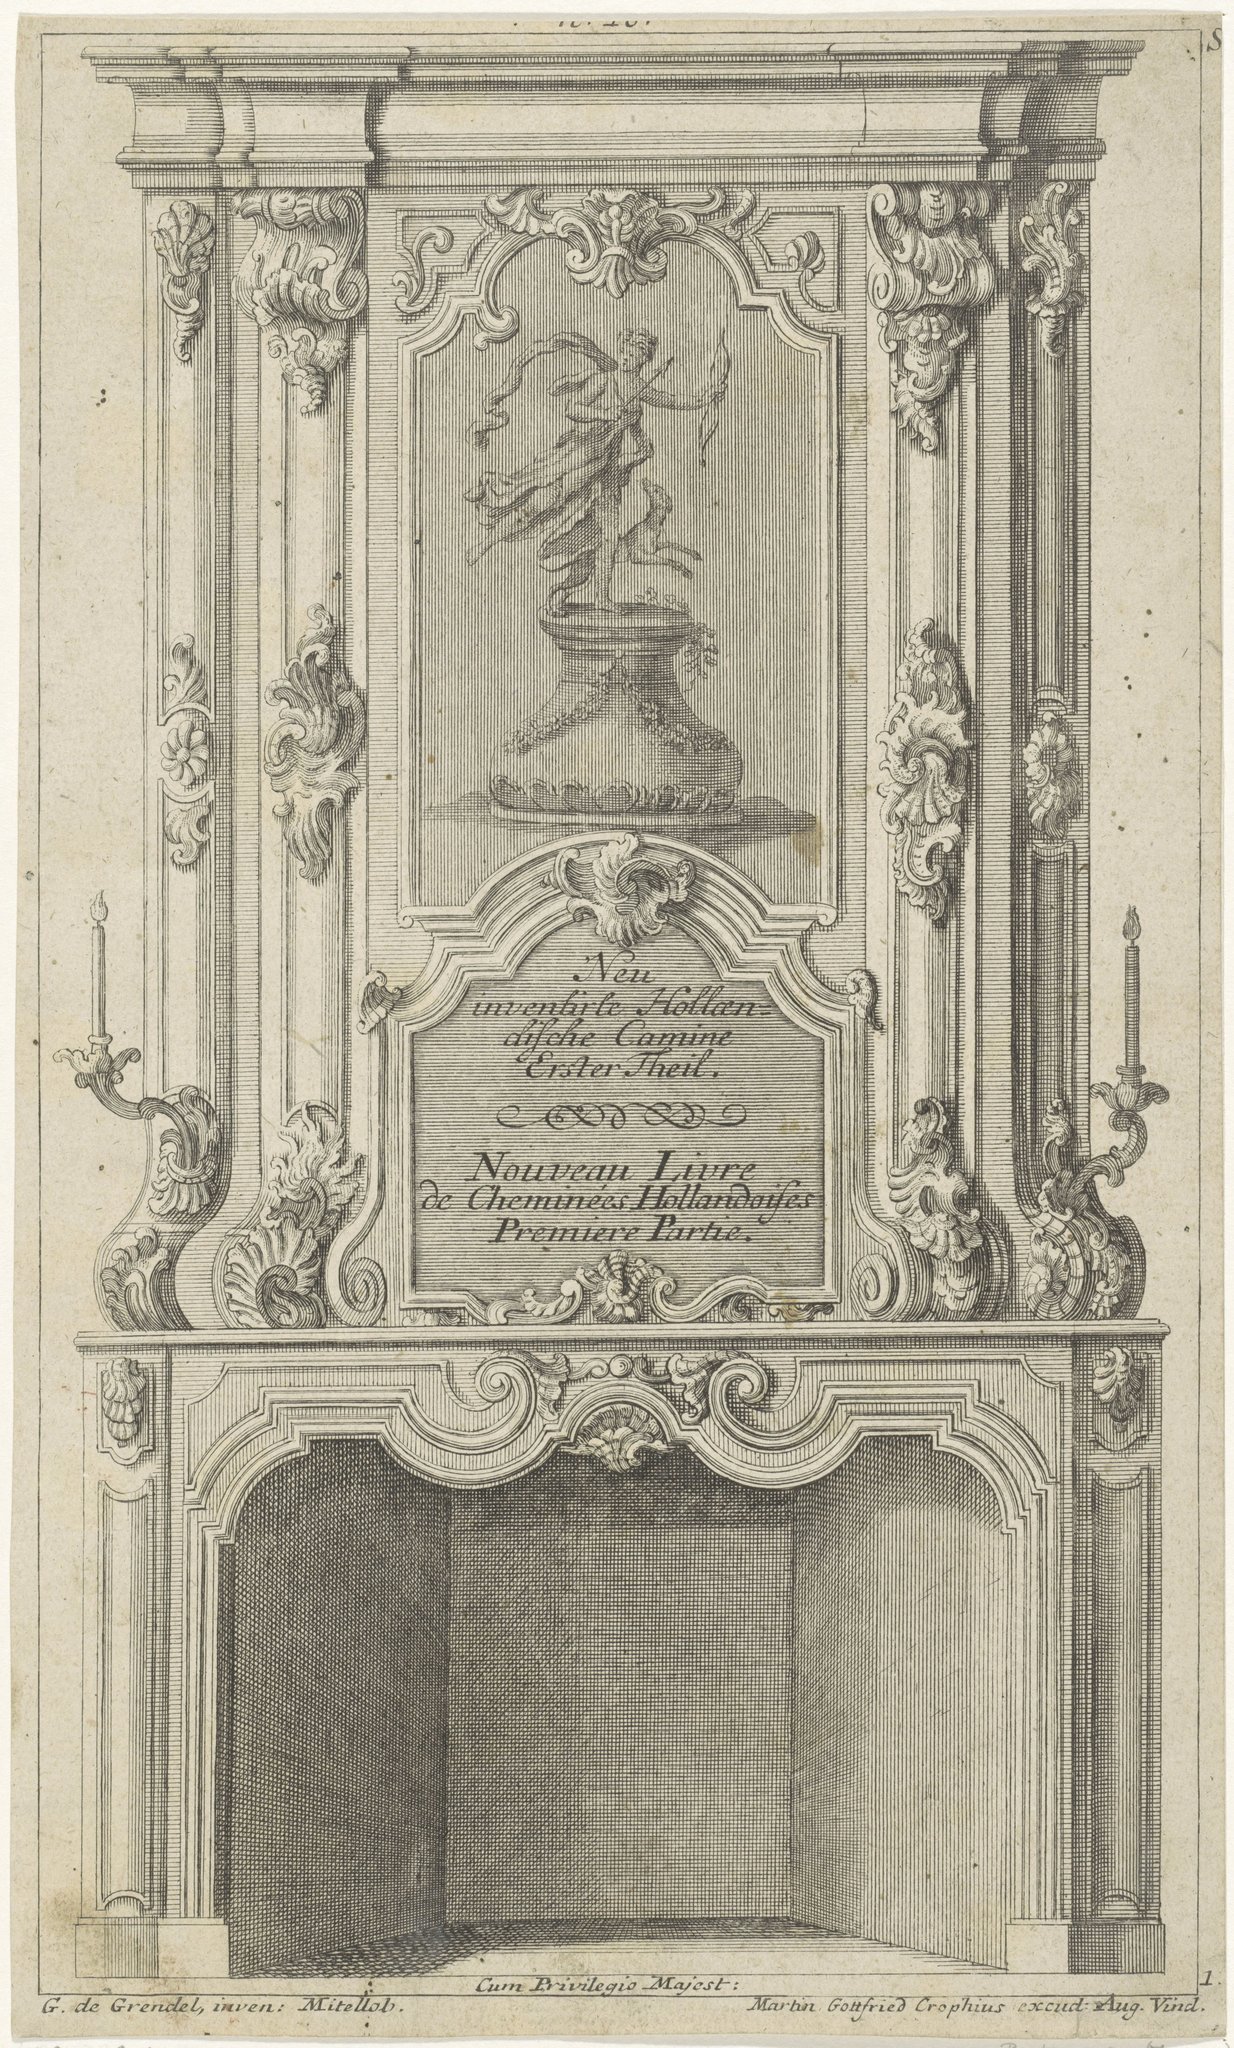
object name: ornament print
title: Ontwerp voor een schoorsteen met Diana als godin van de jacht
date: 1732-1765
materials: paper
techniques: engraving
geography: middelburg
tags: chimney, rocaille ornament, (story of) diana (artemis)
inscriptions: collector's mark: Lugt 2228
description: Ontwerp voor een schoorsteen met een voorstelling van Diana met pijl en boog in de handen en een jachthond op een voetstuk. De schoorsteenmantel is versierd met rocailleornamenten en voluten. Aan weerzijden een kandelaar.